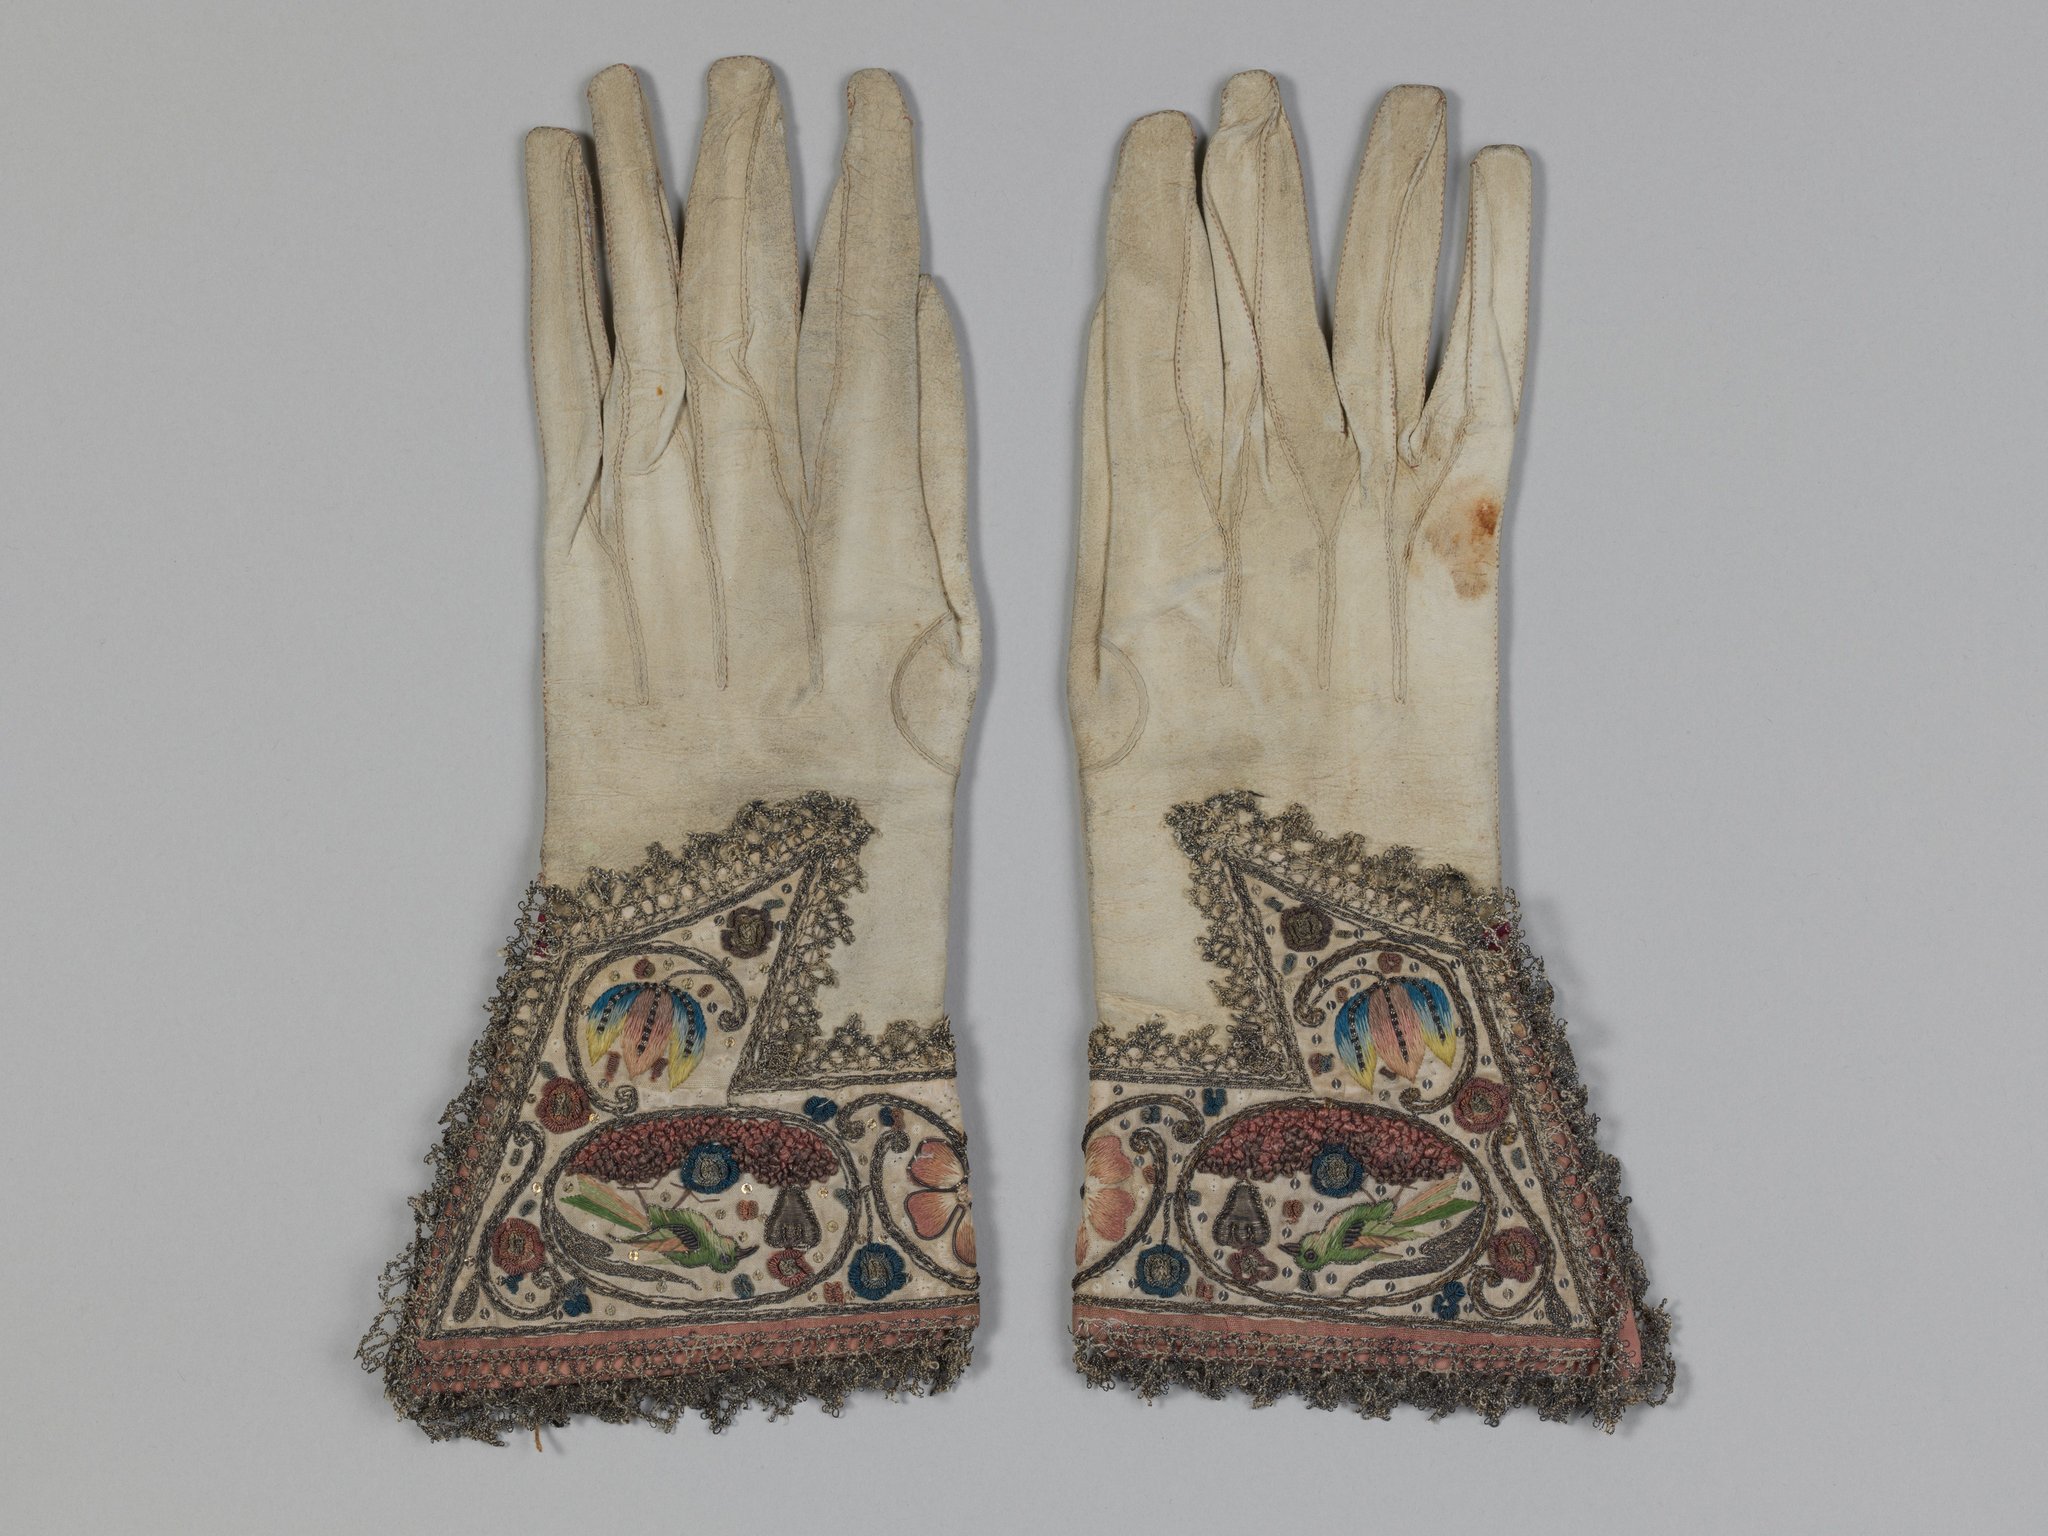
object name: glove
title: Gloves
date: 1620-1640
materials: leather, metal thread, textile, silk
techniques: lace, embroidery, stitching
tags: birds,flowers